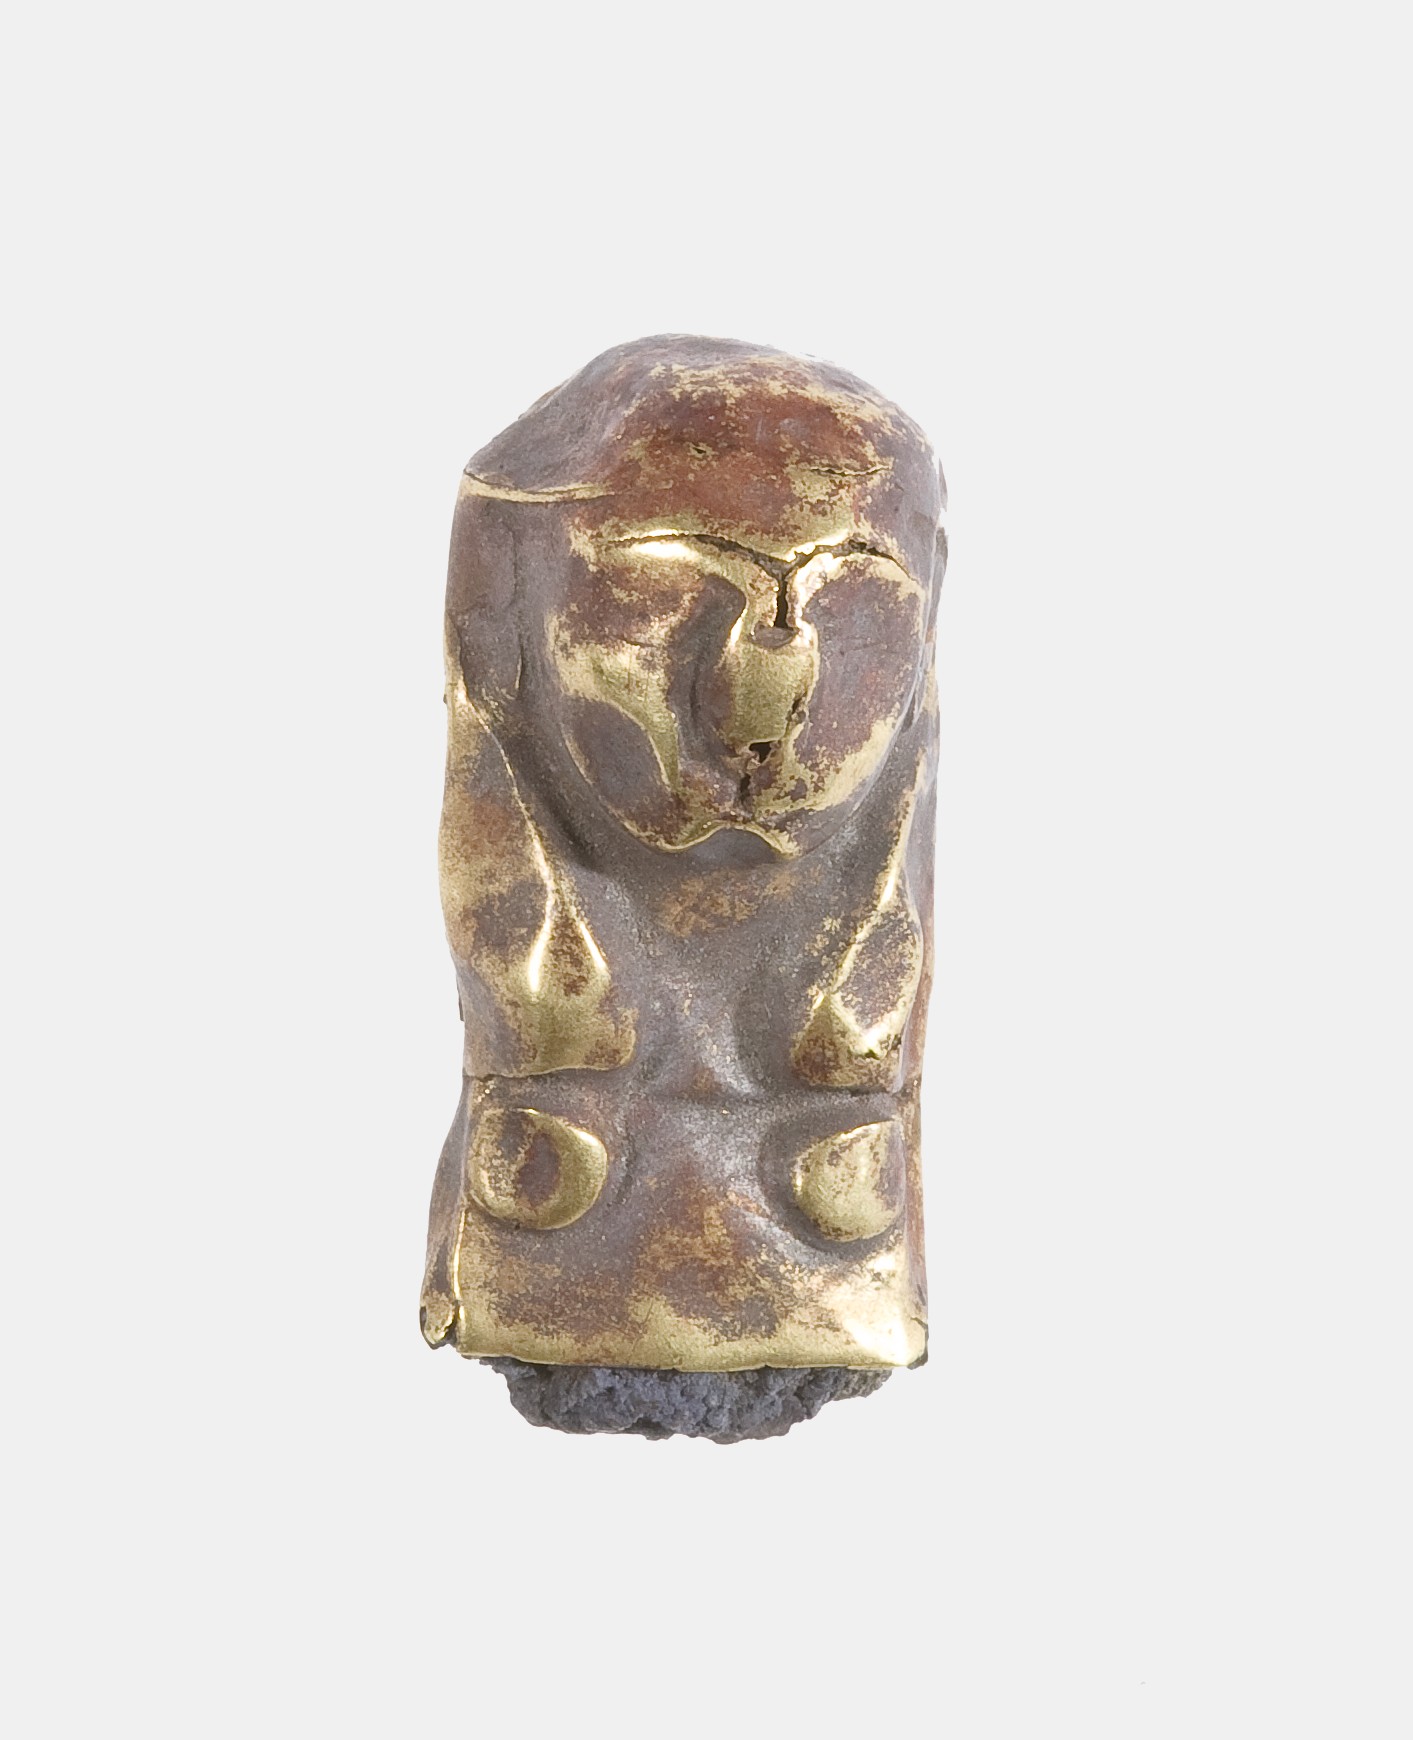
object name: amulet, handle of a peseshkef opening of the mouth tool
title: Part of "Opening of the Mouth" peseshkef amulet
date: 1981-1640 BCE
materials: copper, gold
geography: egypt